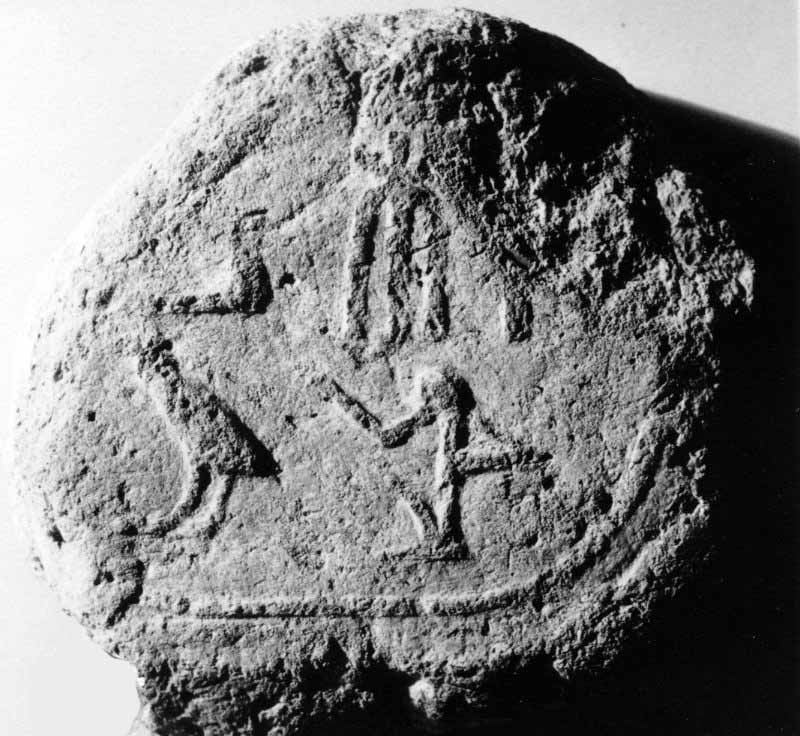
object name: cone, ahmose, oval stamp, sealer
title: Funerary Cone of the Sealer Ahmose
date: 1550-1295 BCE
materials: pottery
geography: egypt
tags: hieroglyphs